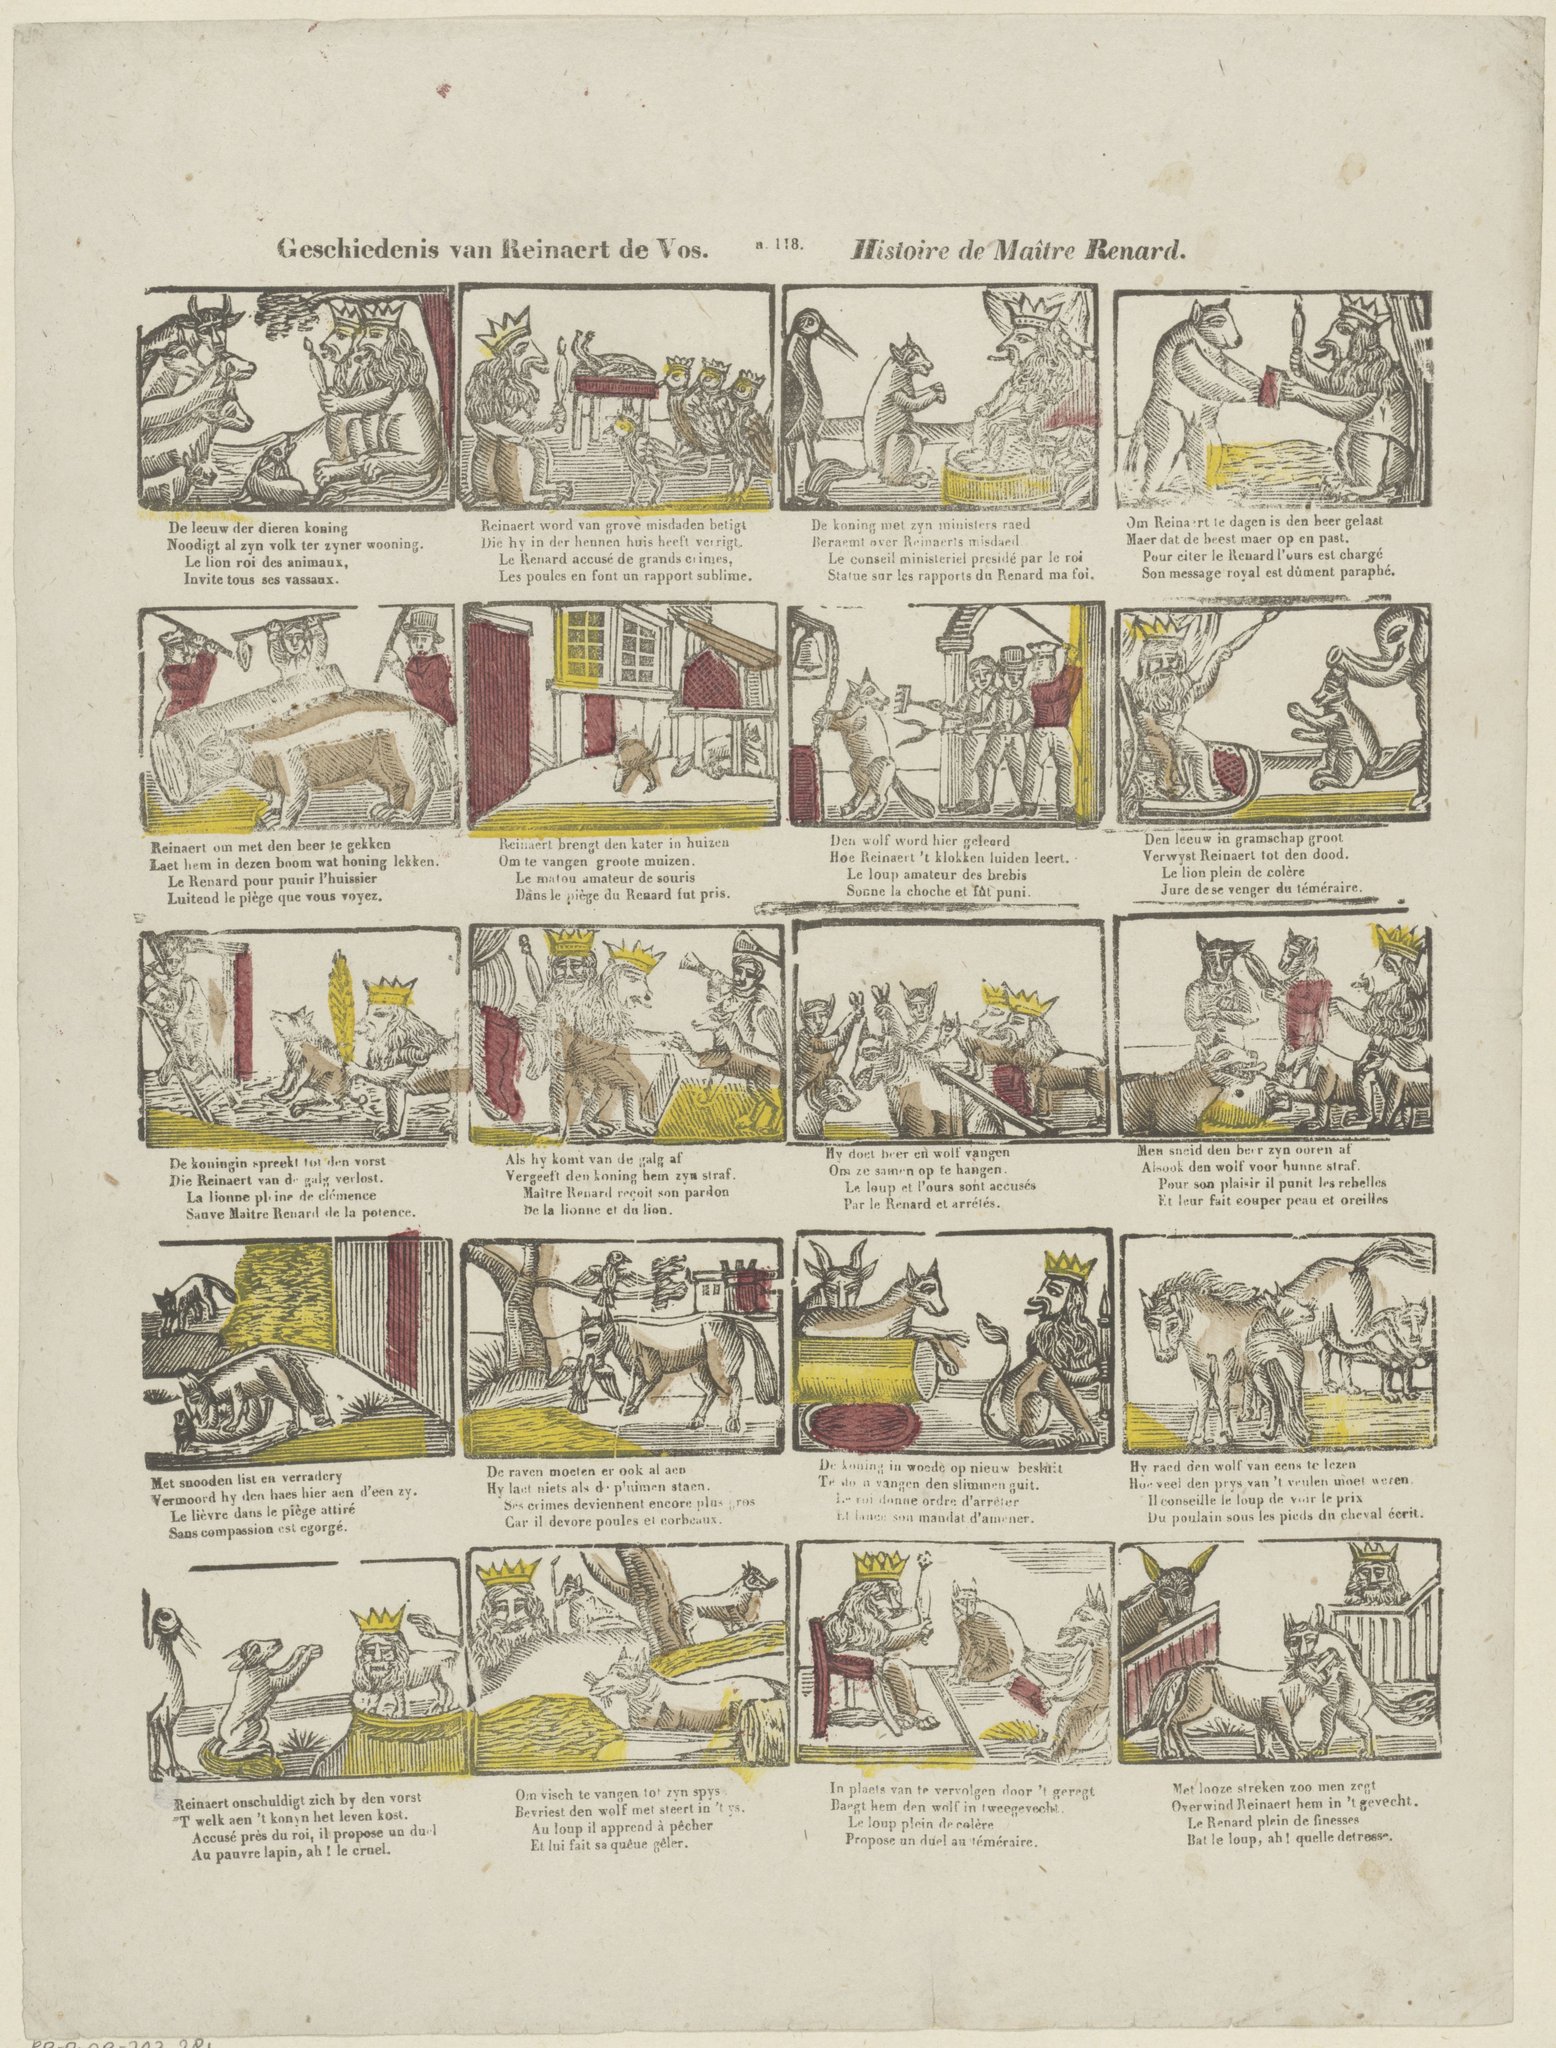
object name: print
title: Geschiedenis van Reinaert de vos / Histoire de mâitre Renard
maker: Anonymous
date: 1856-1900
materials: paper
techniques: colour, letterpress printing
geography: turnhout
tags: fable of reynard the fox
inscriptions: collector's mark: Lugt 2760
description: Blad met 20 voorstellingen uit het epos van Reinaert de vos. Onder elke afbeelding een tweeregelig vers in het Nederlands en in het Frans. Genummerd midden boven: n. 118.